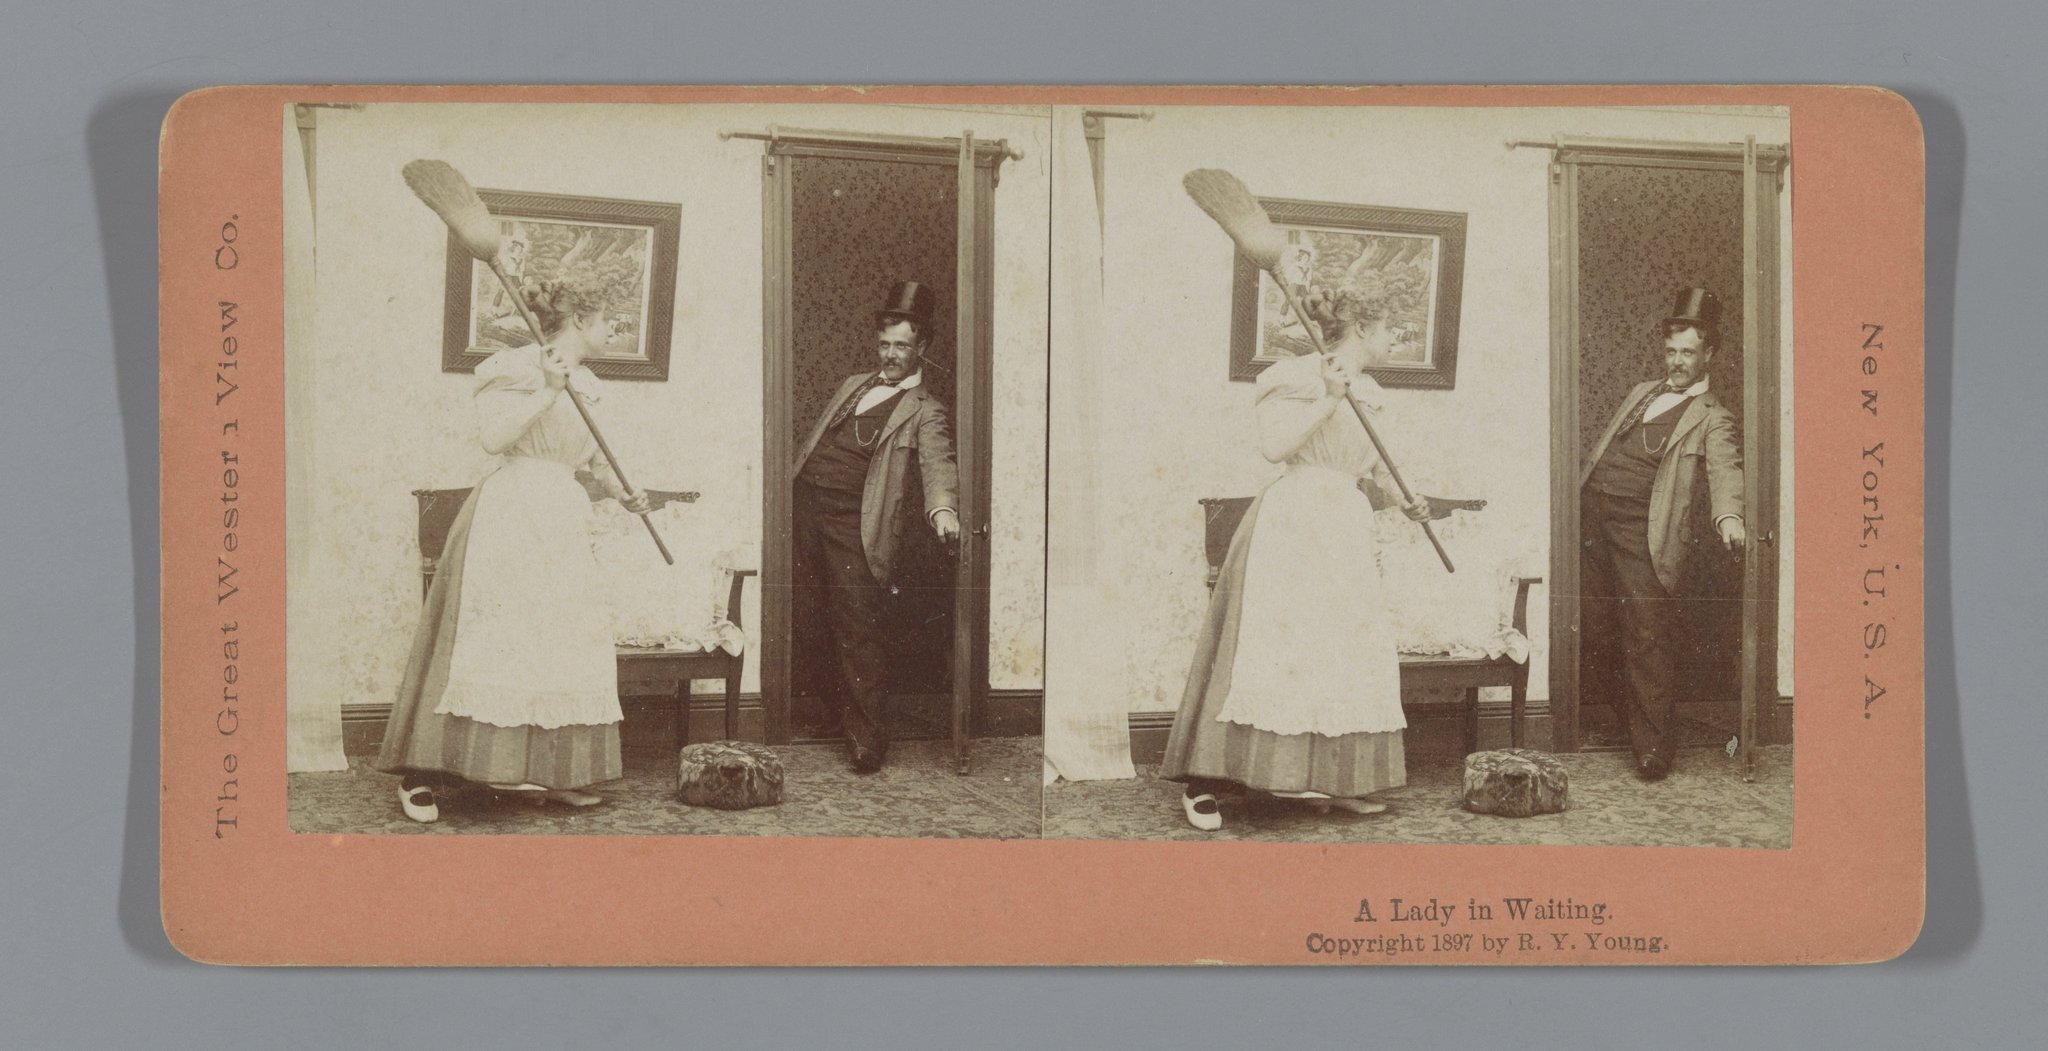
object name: stereograph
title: Vrouw met bezem wacht man op in deuropening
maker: roddo y. young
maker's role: publisher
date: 1897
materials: cardboard, photographic support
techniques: albumen print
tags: man and wife quarrelling, 'marriage à la mode', shrubs: broom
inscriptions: : ‘New York U.S.A.’, stamp: ‘Gebr. Douwes / Ateliers / Warmoesstraat 78 / Amsterdam’, name: ‘Copyright 1897 by R.Y. Young’